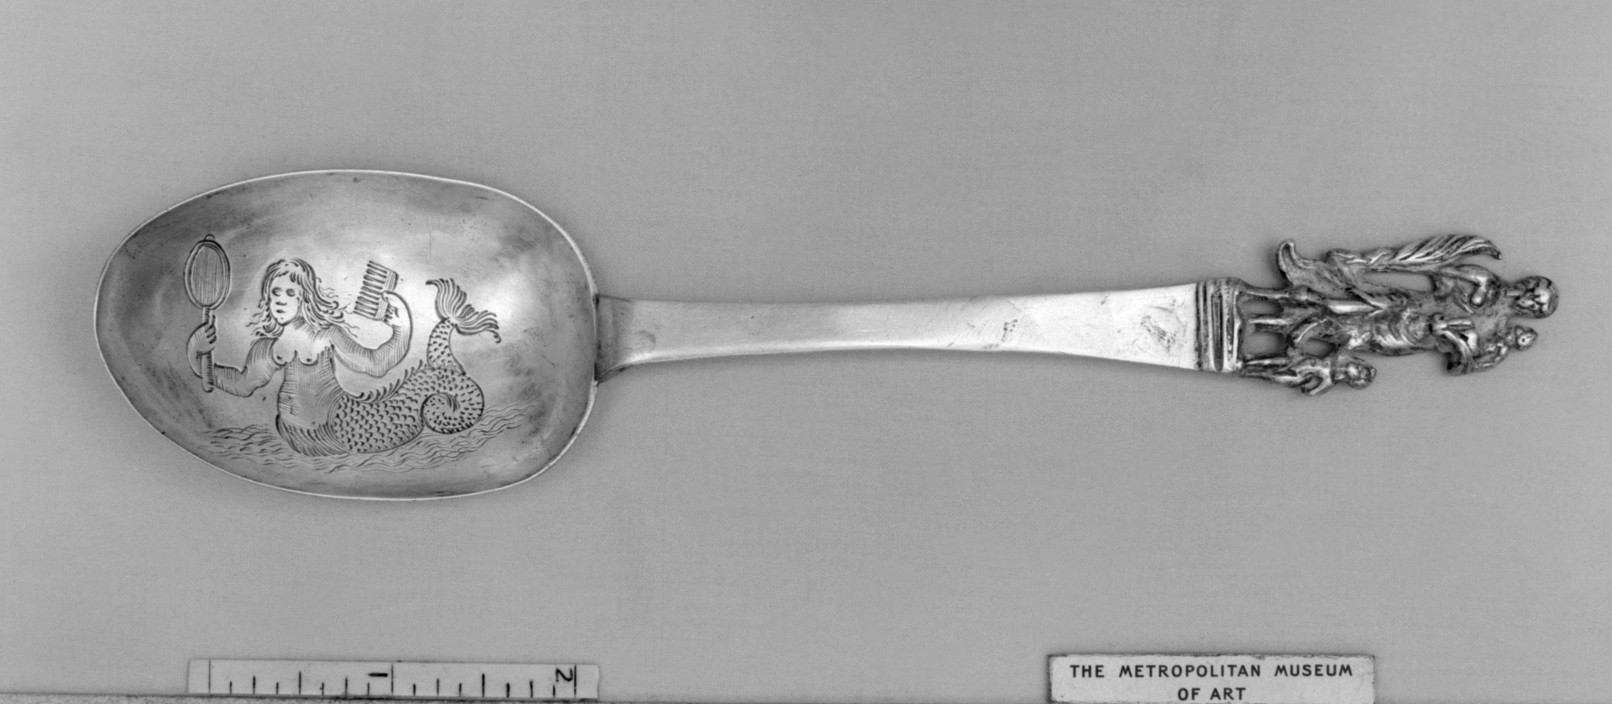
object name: spoon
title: Figure-top spoon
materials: silver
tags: human figures,mermaids